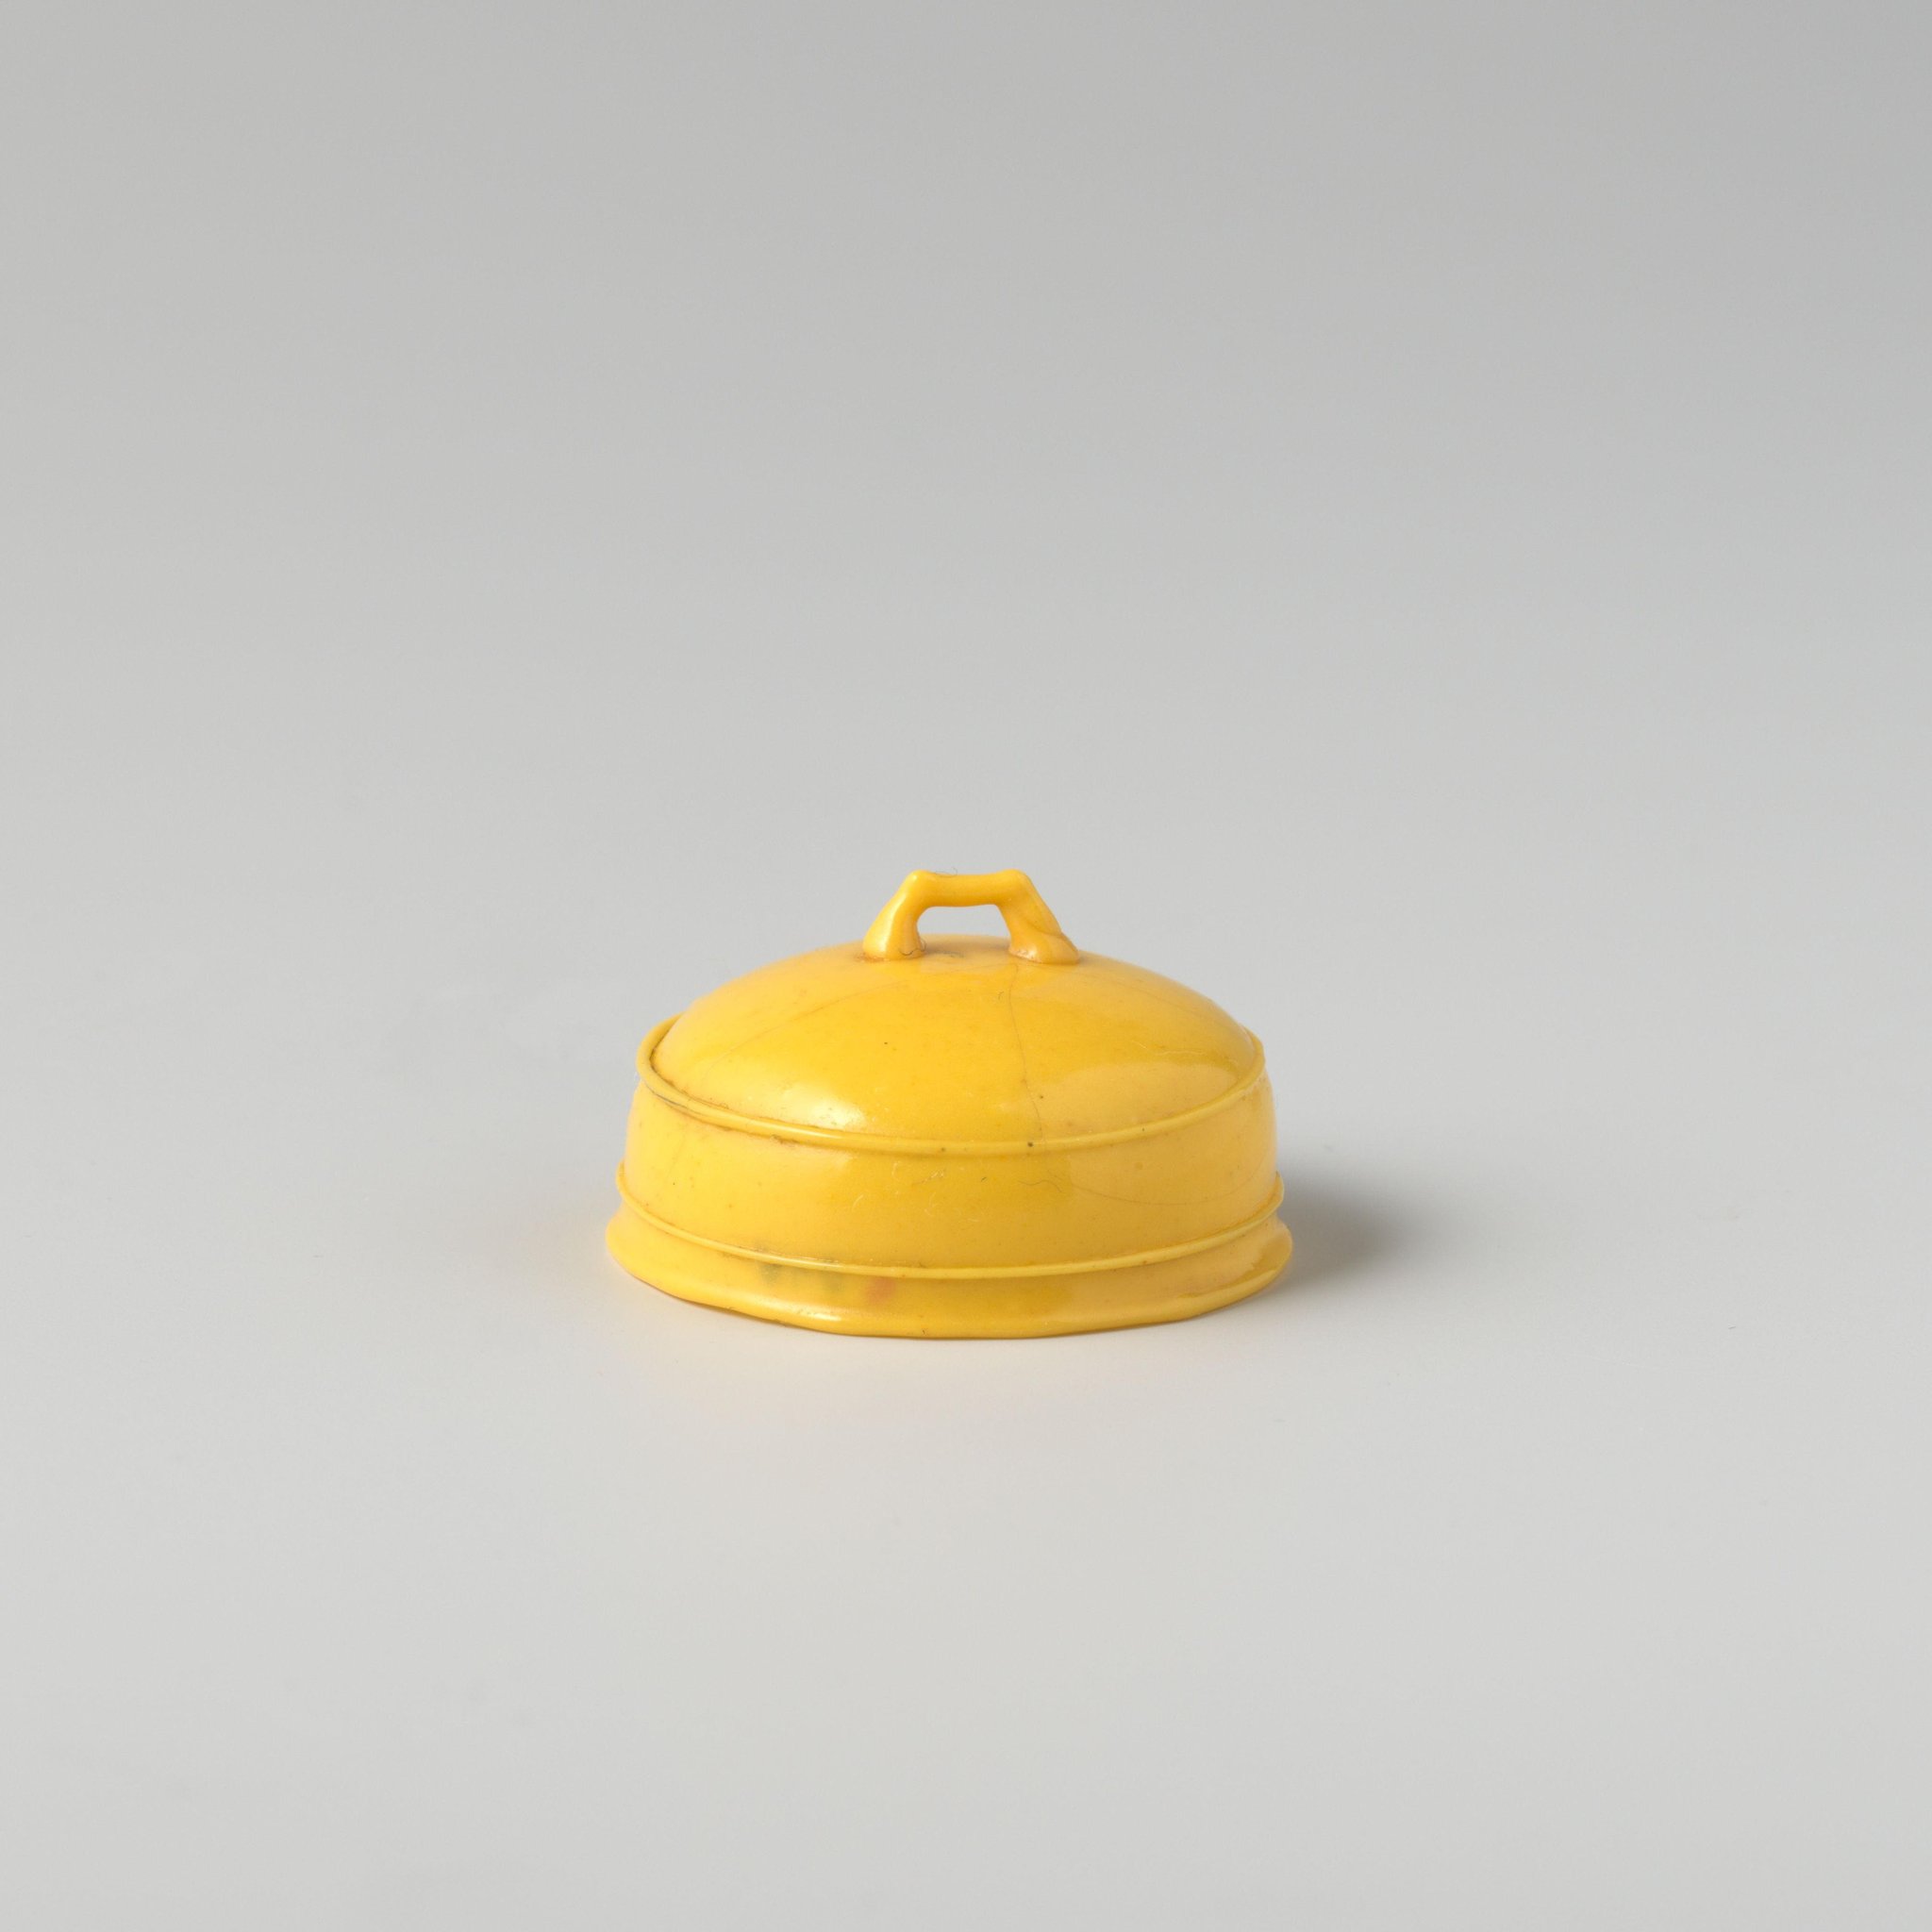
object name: miniature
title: Deksel of stolp van opaak geel glas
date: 1675-1700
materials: glass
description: Deksel of stolp van opaak geel glas, bol, vrij laag model met drie opgelegde glasdraden en een hoekig handvat.